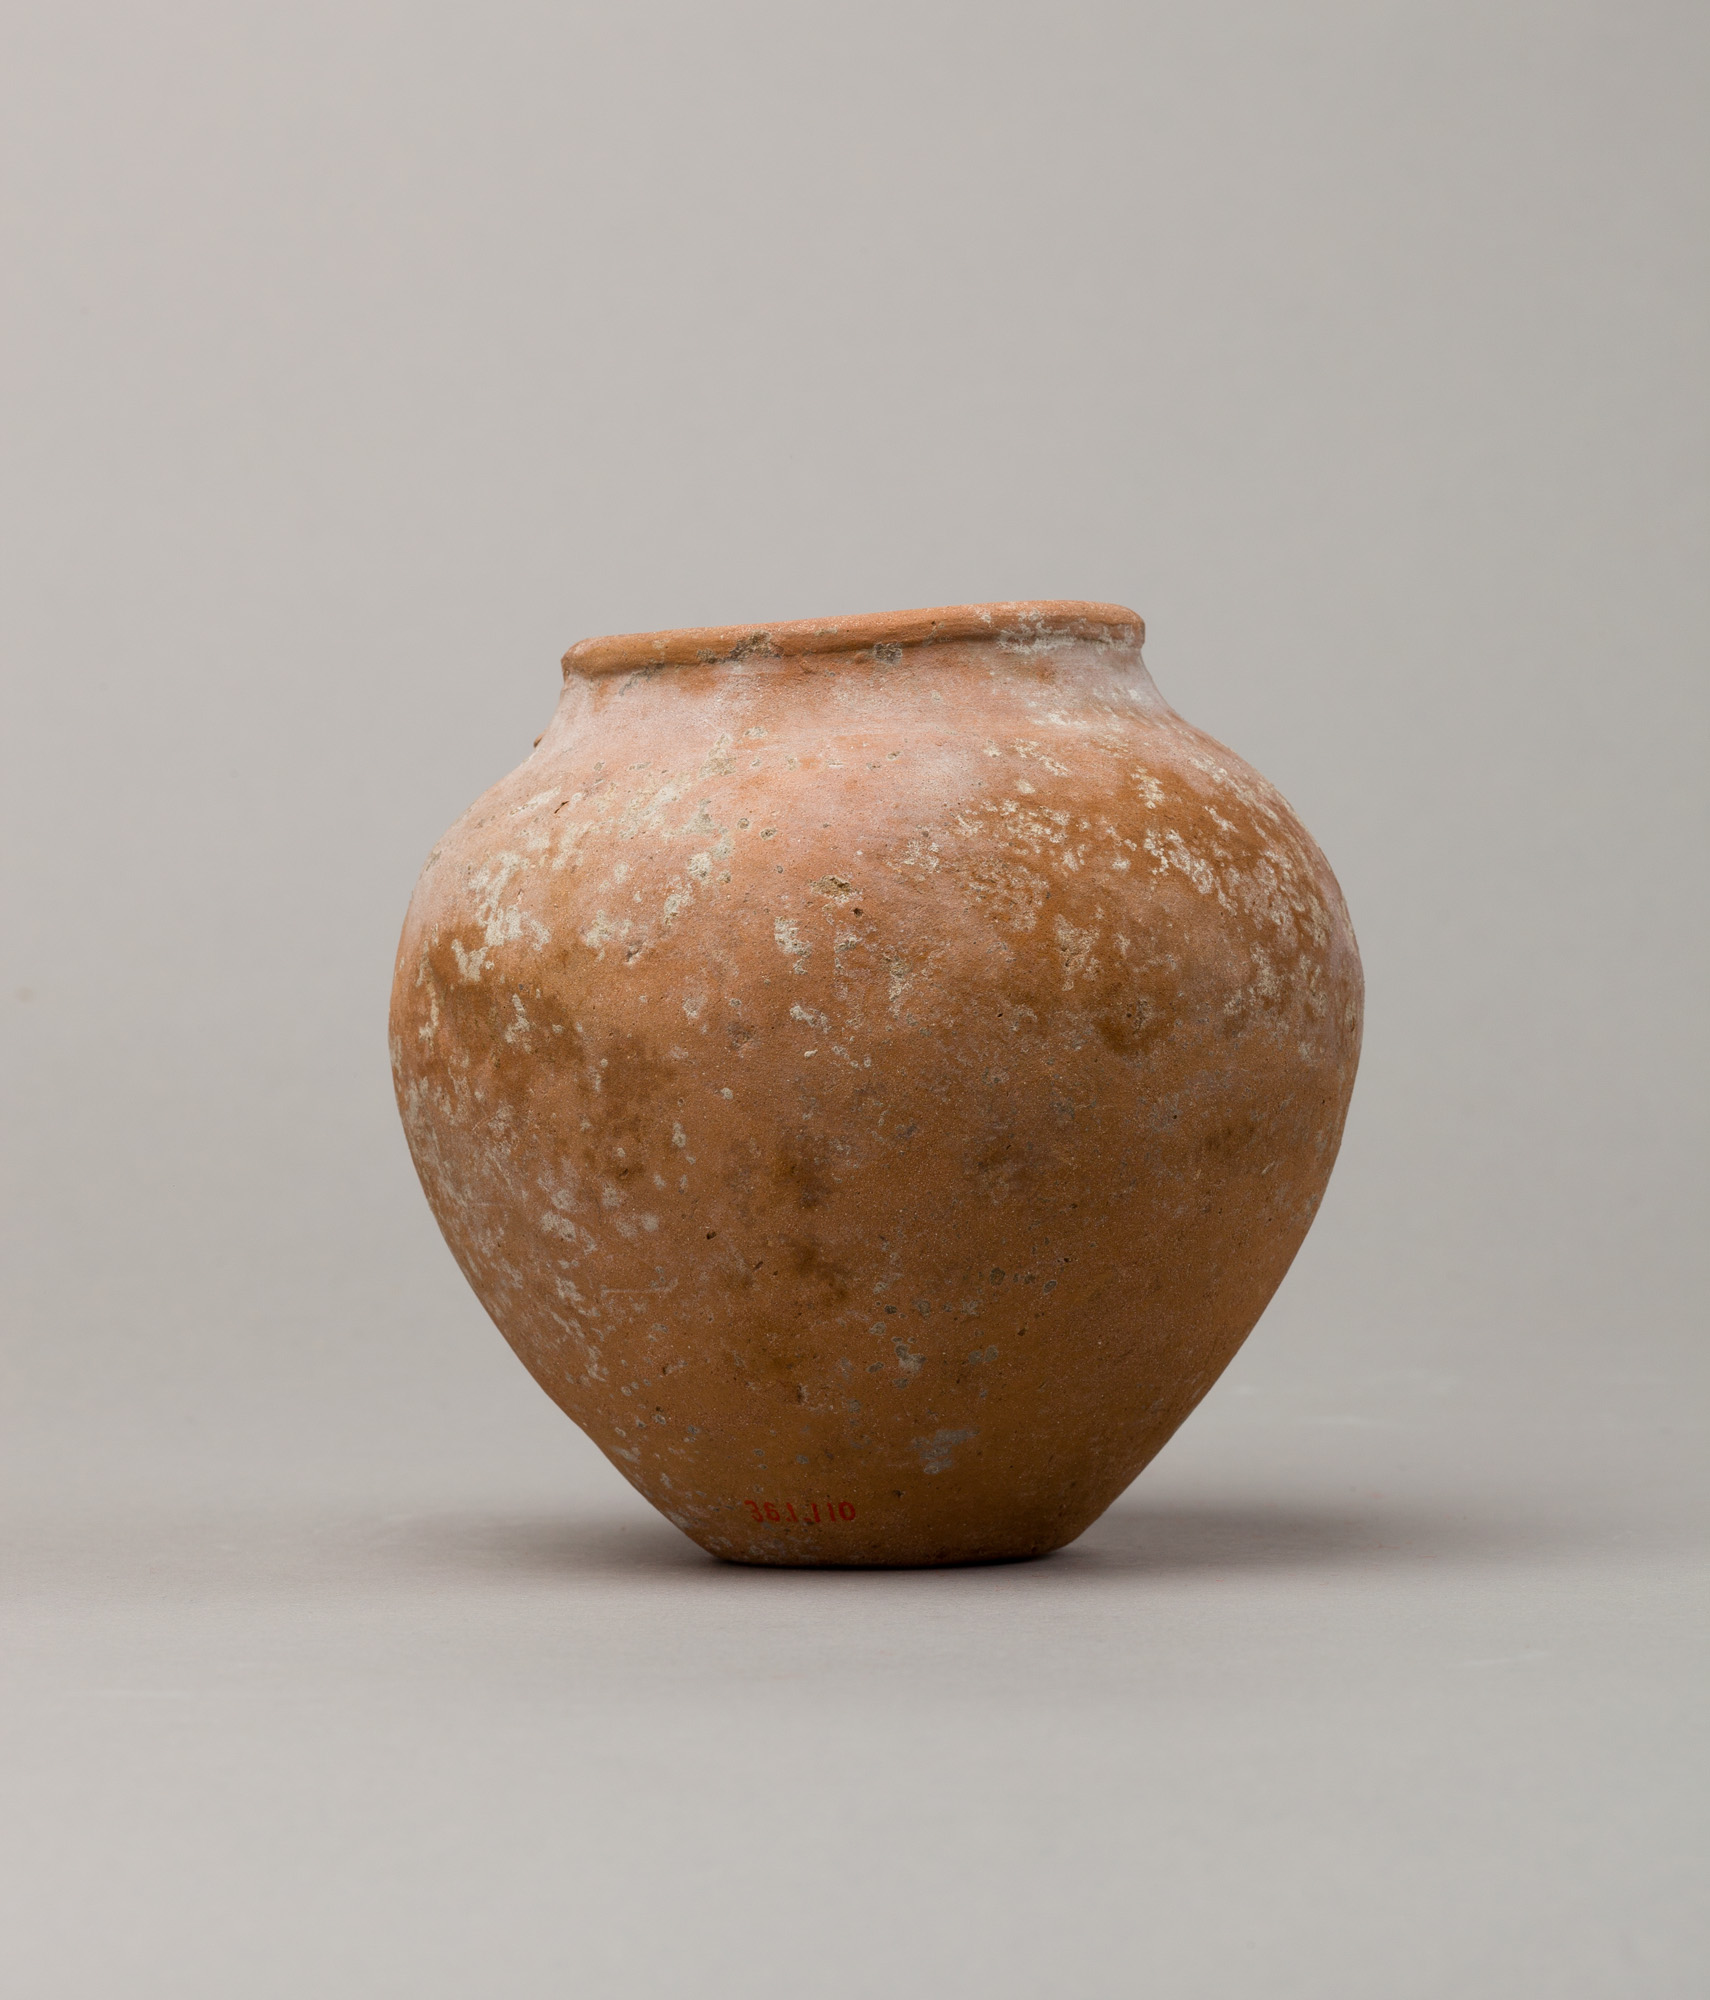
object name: jar, gooleh ware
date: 3850-2960 BCE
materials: pottery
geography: egypt